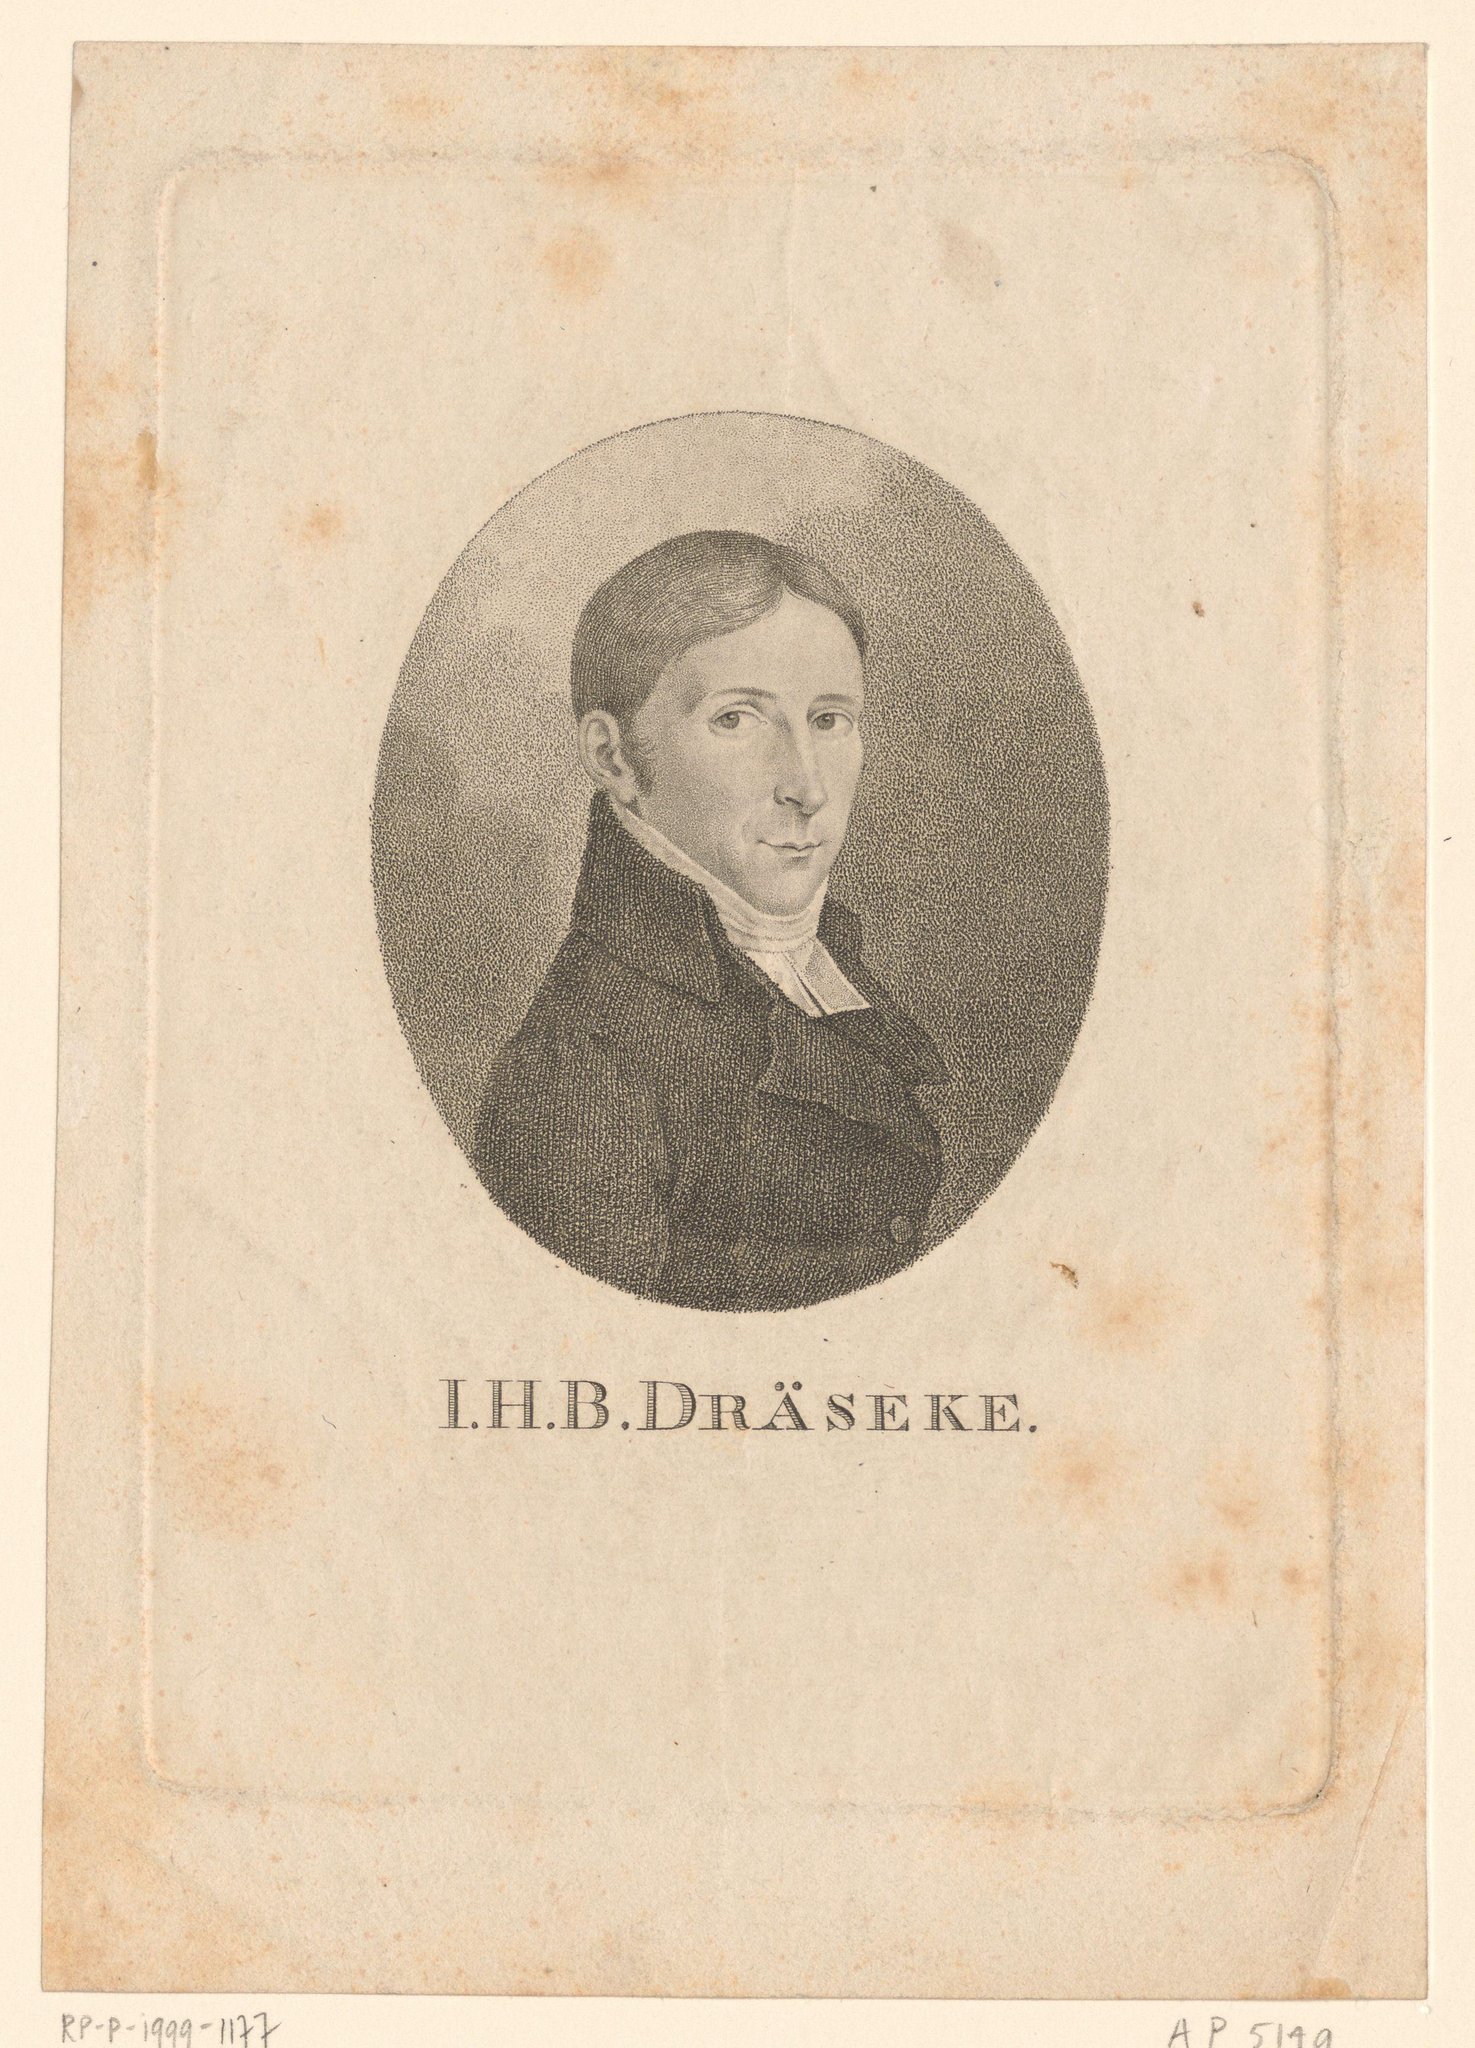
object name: print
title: Portret van Johann Heinrich Bernhard Dräseke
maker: Anonymous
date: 1812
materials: paper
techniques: engraving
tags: theologian, historical persons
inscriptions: collector's mark: Lugt 2760, collector's mark: Lugt 2228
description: Prent mogelijk uit: Dräseke, Johann Heinrich Bernhard. Predigten für denkende Verehrer Jesus. 5 dln. Lüneburg: Herold en Walstab, 1812, dl. 5.